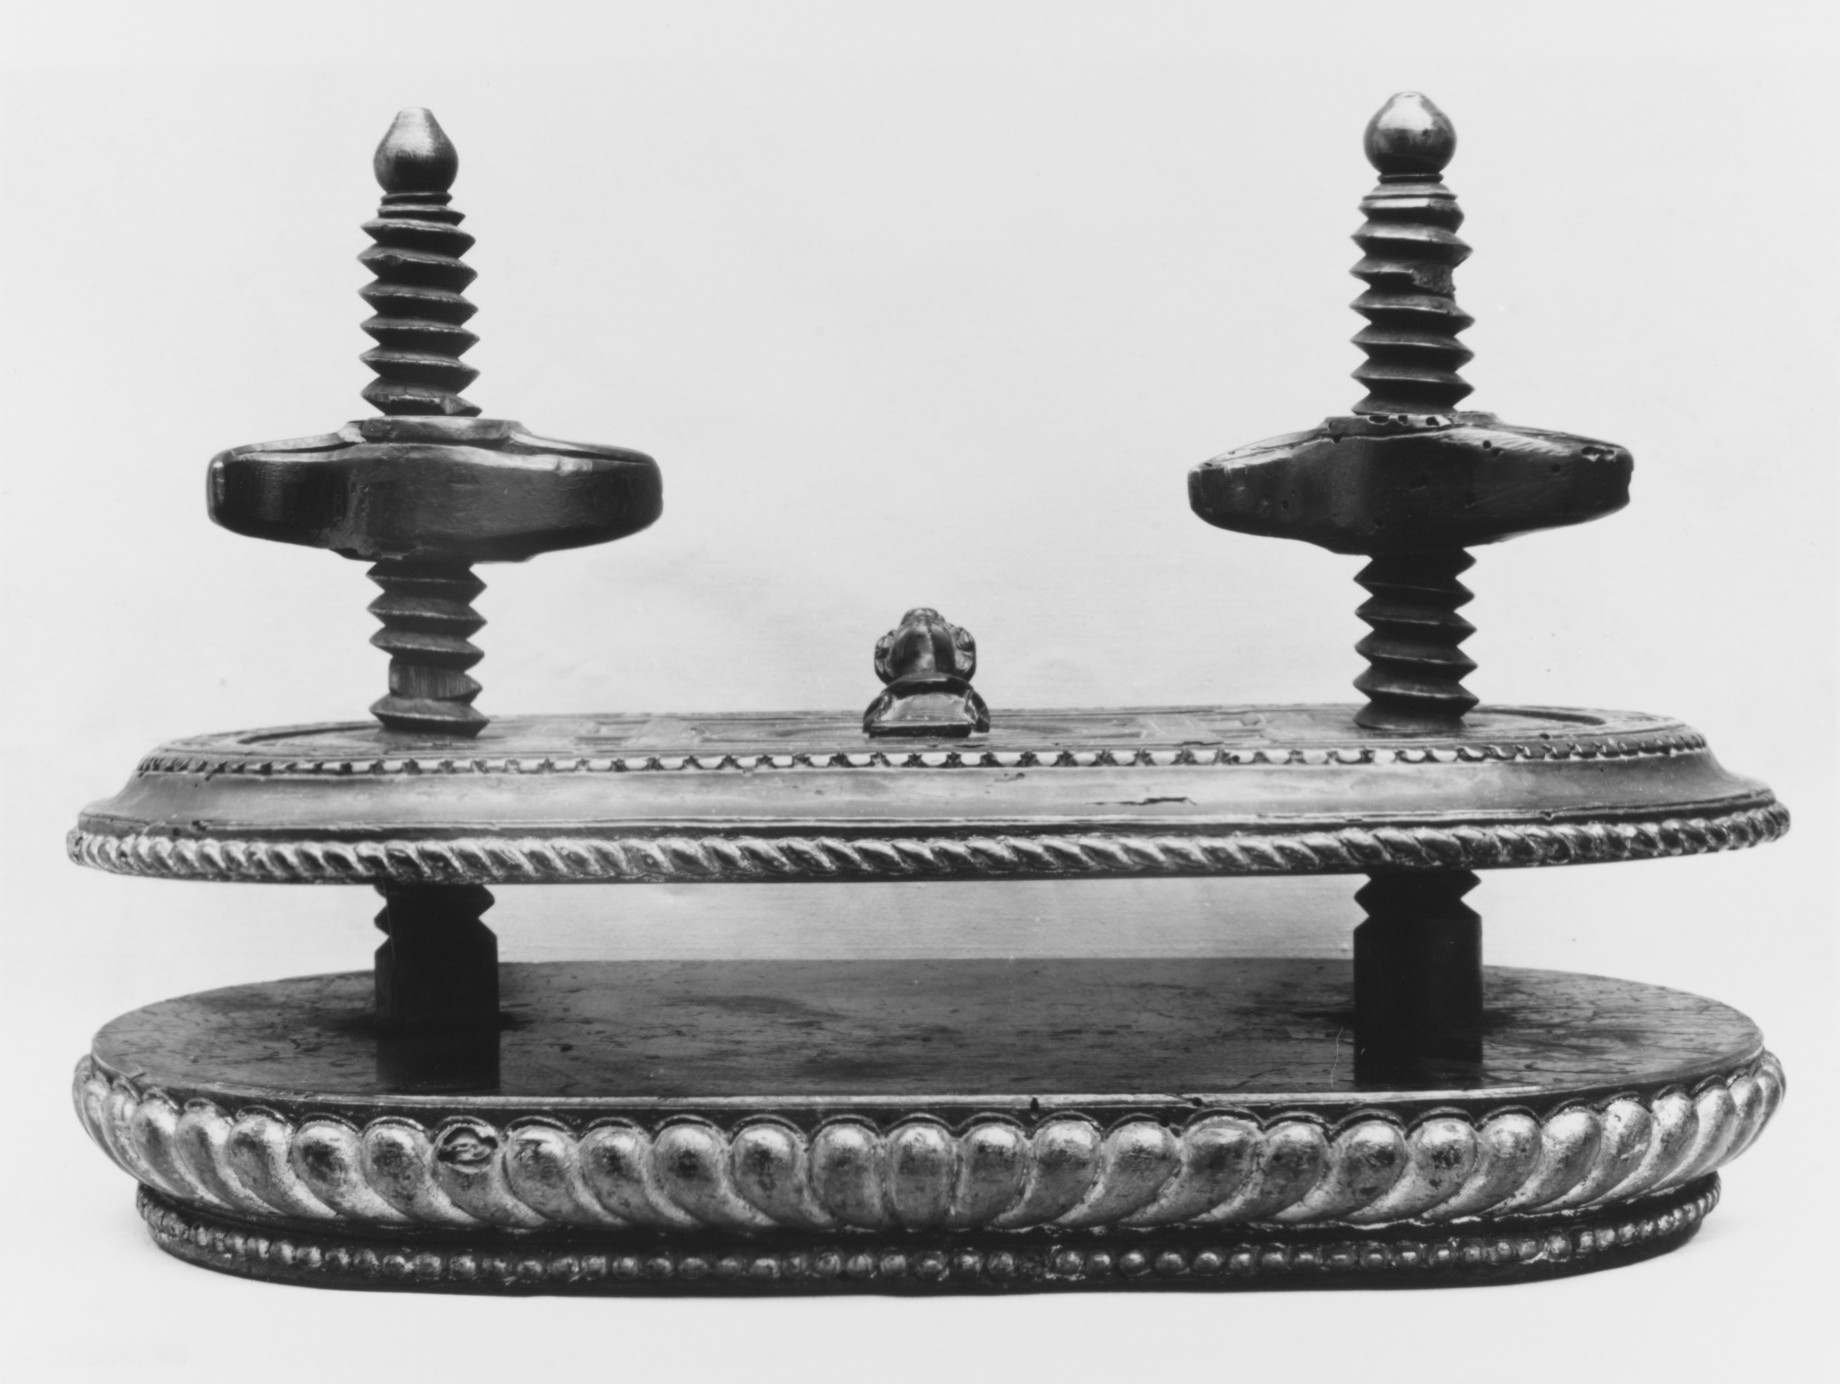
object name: table press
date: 1501-1600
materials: wood